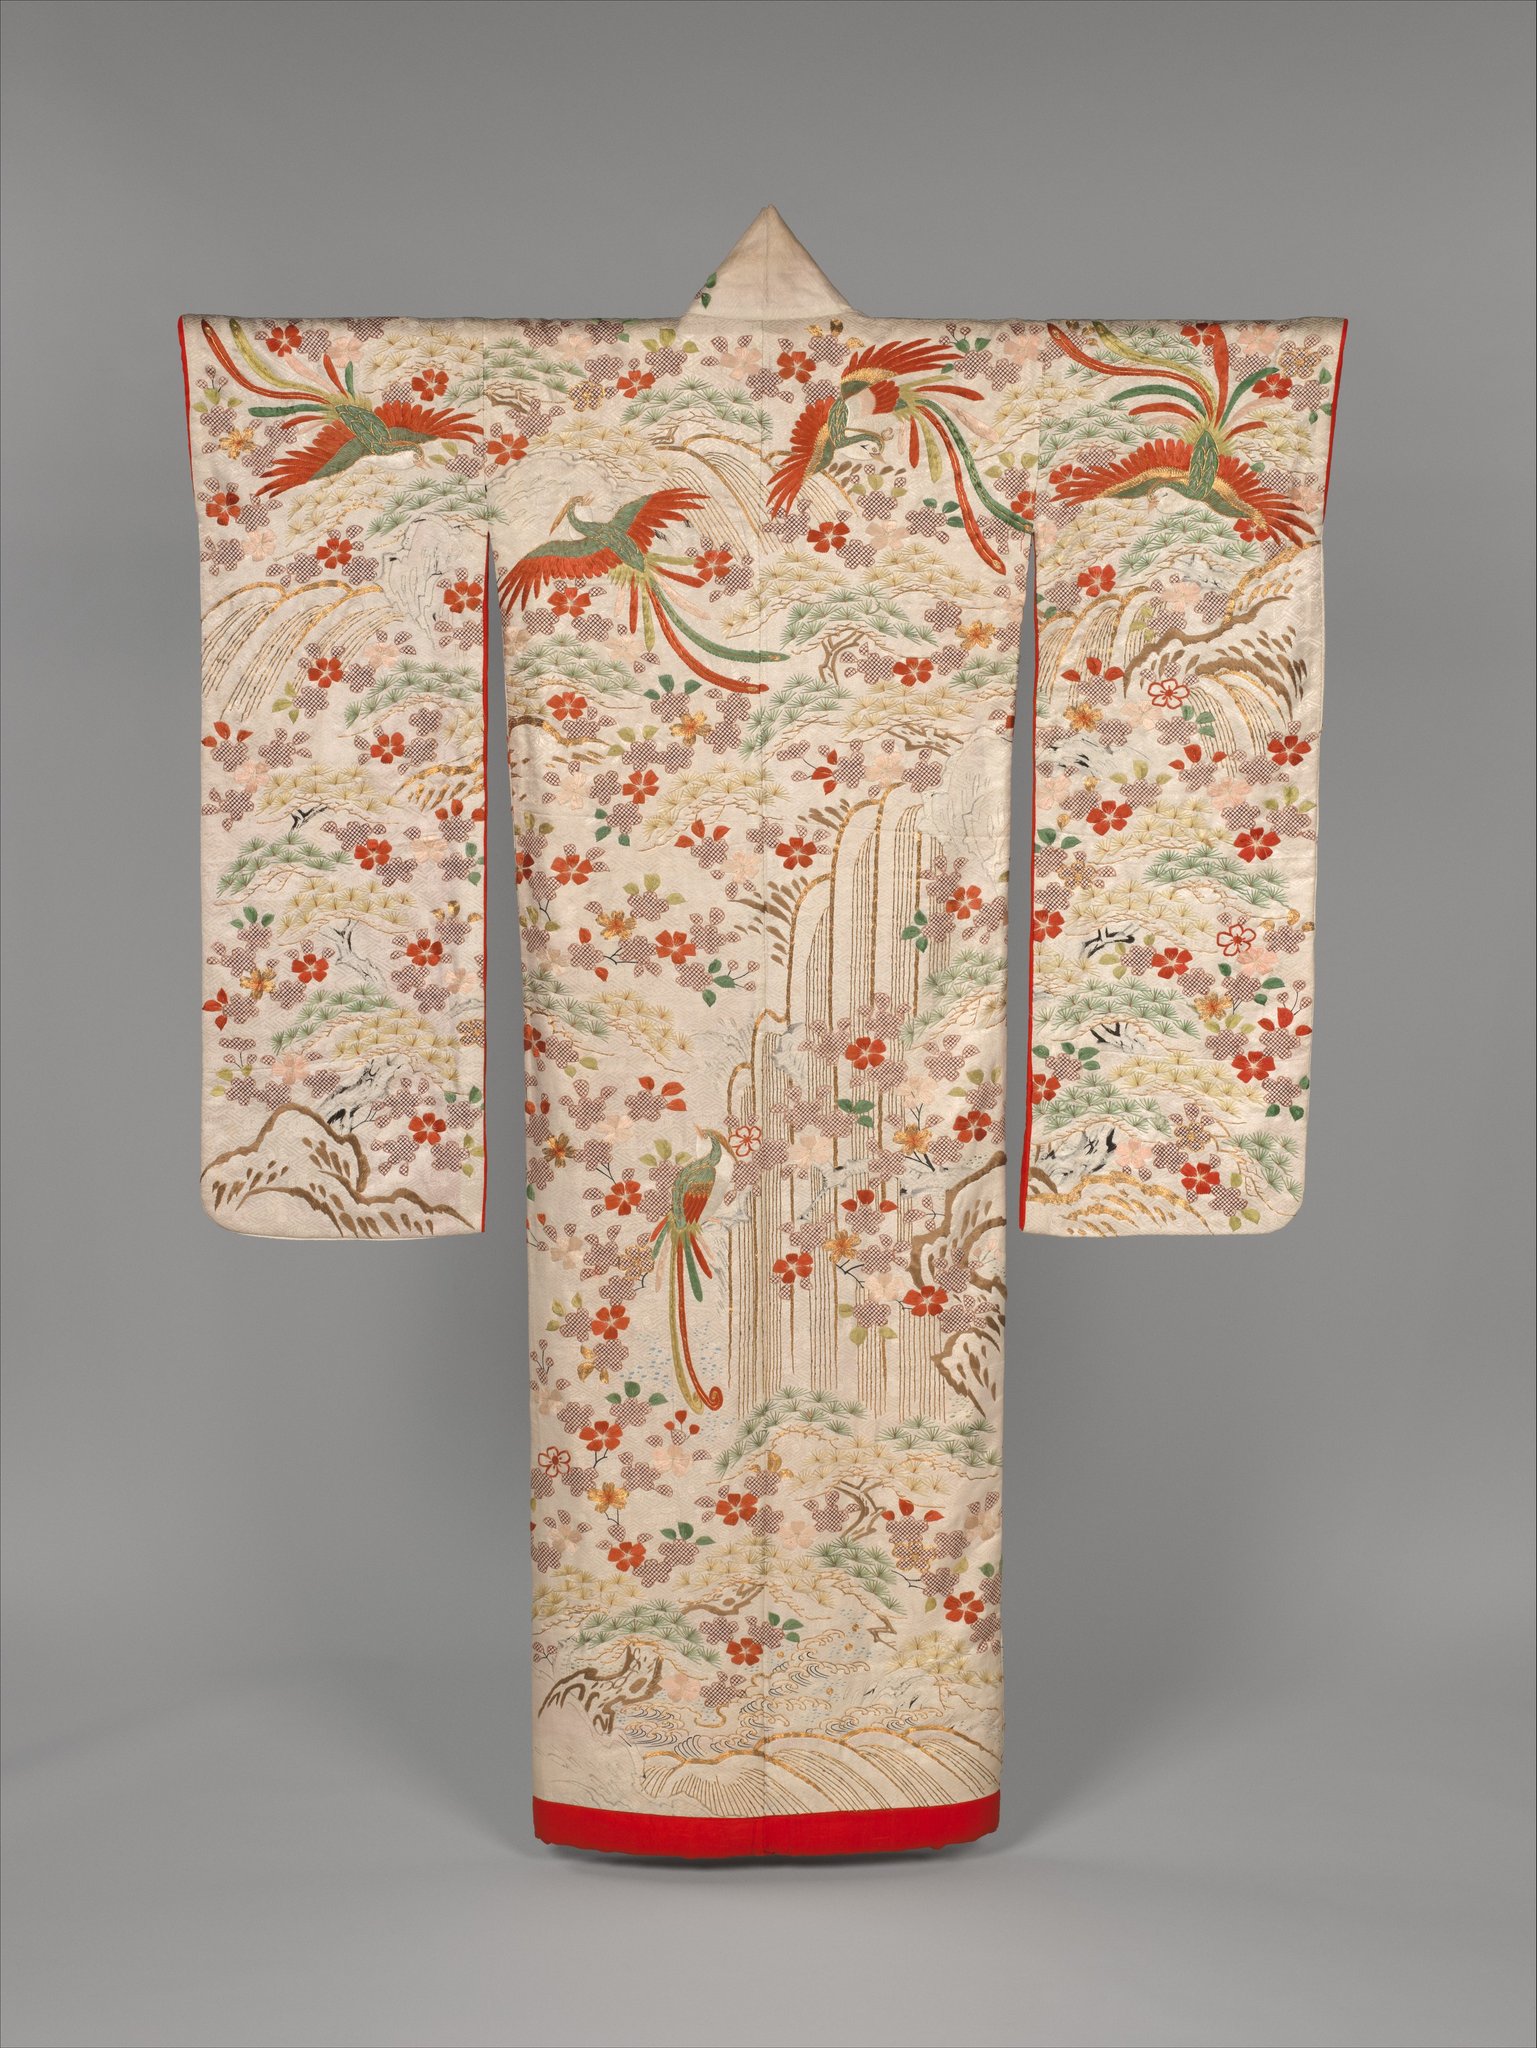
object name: robe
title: Over Robe (Uchikake) with Long-Tailed Birds in a Landscape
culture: japanese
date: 1751-1800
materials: metal thread, paste, silk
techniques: damask, embroidery, resist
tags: birds